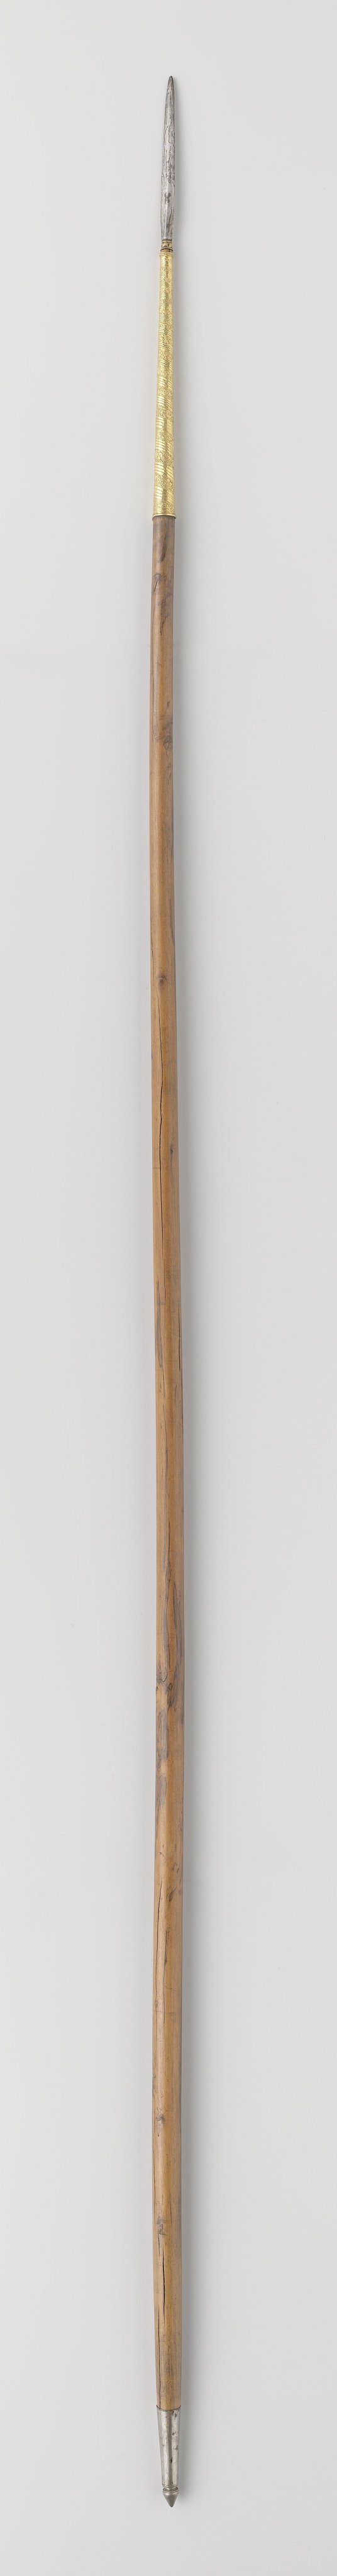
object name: pike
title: Lans van het wapenrek door Indonesische leiders geschonken aan Gouverneur-Generaal J.C. baron Baud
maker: Anonymous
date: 1800-1900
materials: iron, wood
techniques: cutting, engraving, forging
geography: java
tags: the hague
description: Lans met smalle kling, met aan de bovenzijde van de ronde houten schacht verguld koper, met afwisselend vier gedraaide banen en gegraveerde bloem- en bladmotieven. Onderaan de schacht een ijzeren omhulsel met een omgekeerde conische punt.